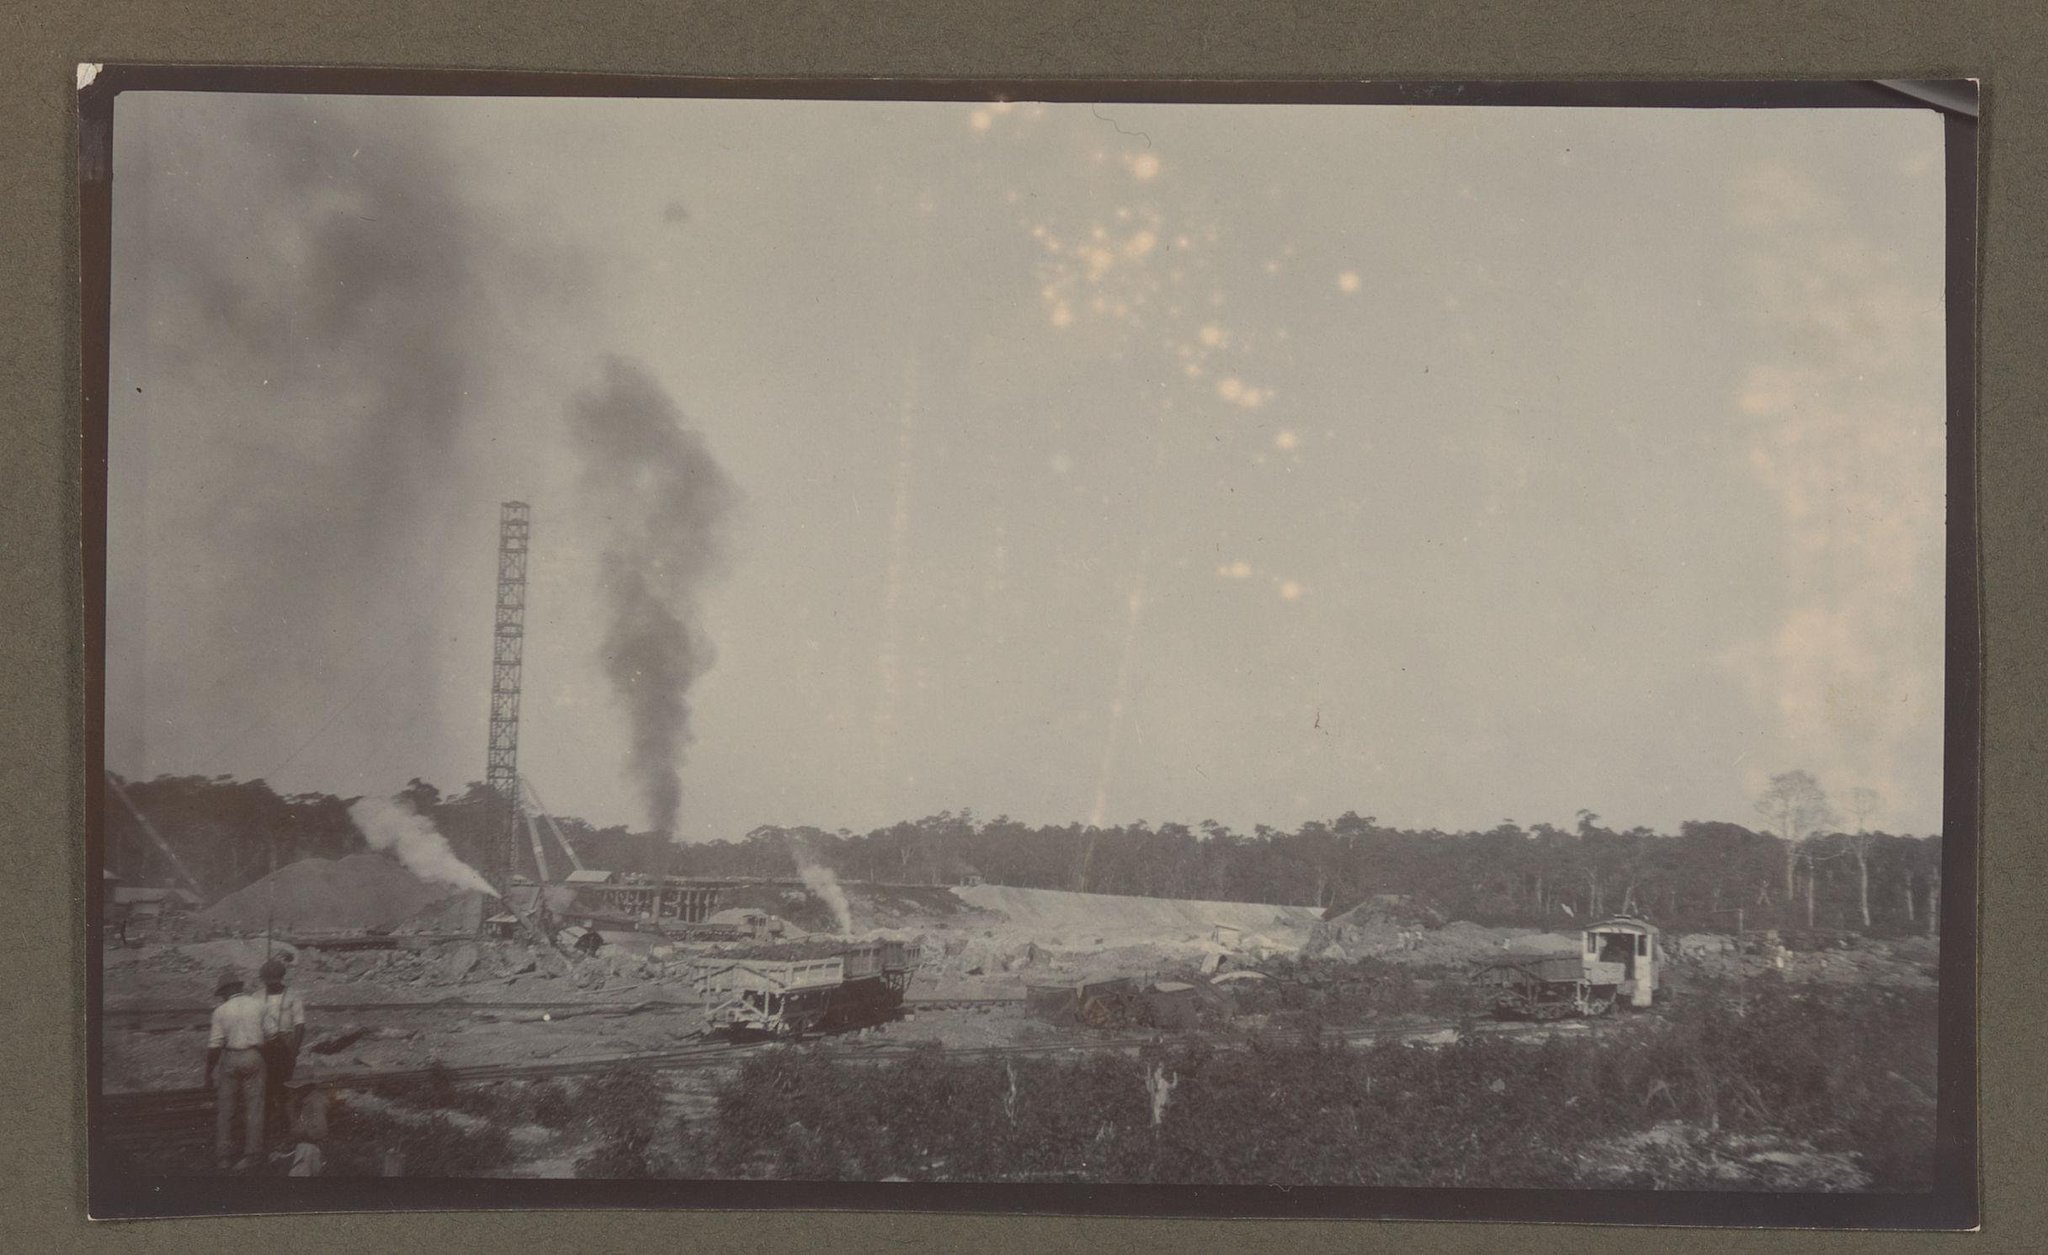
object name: photograph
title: Mijn en fabriek in Moengo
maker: Anonymous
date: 1925-1927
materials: photographic support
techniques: photography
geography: suriname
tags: jetten, familie, moengo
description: Terrein van de mijn en fabriek in Moengo. Foto op een bladzijde van een los albumblad. Onderdeel van het ensemble met foto's van de familie van ingenieur Jetten in de mijnbouwstad Moengo in Suriname.